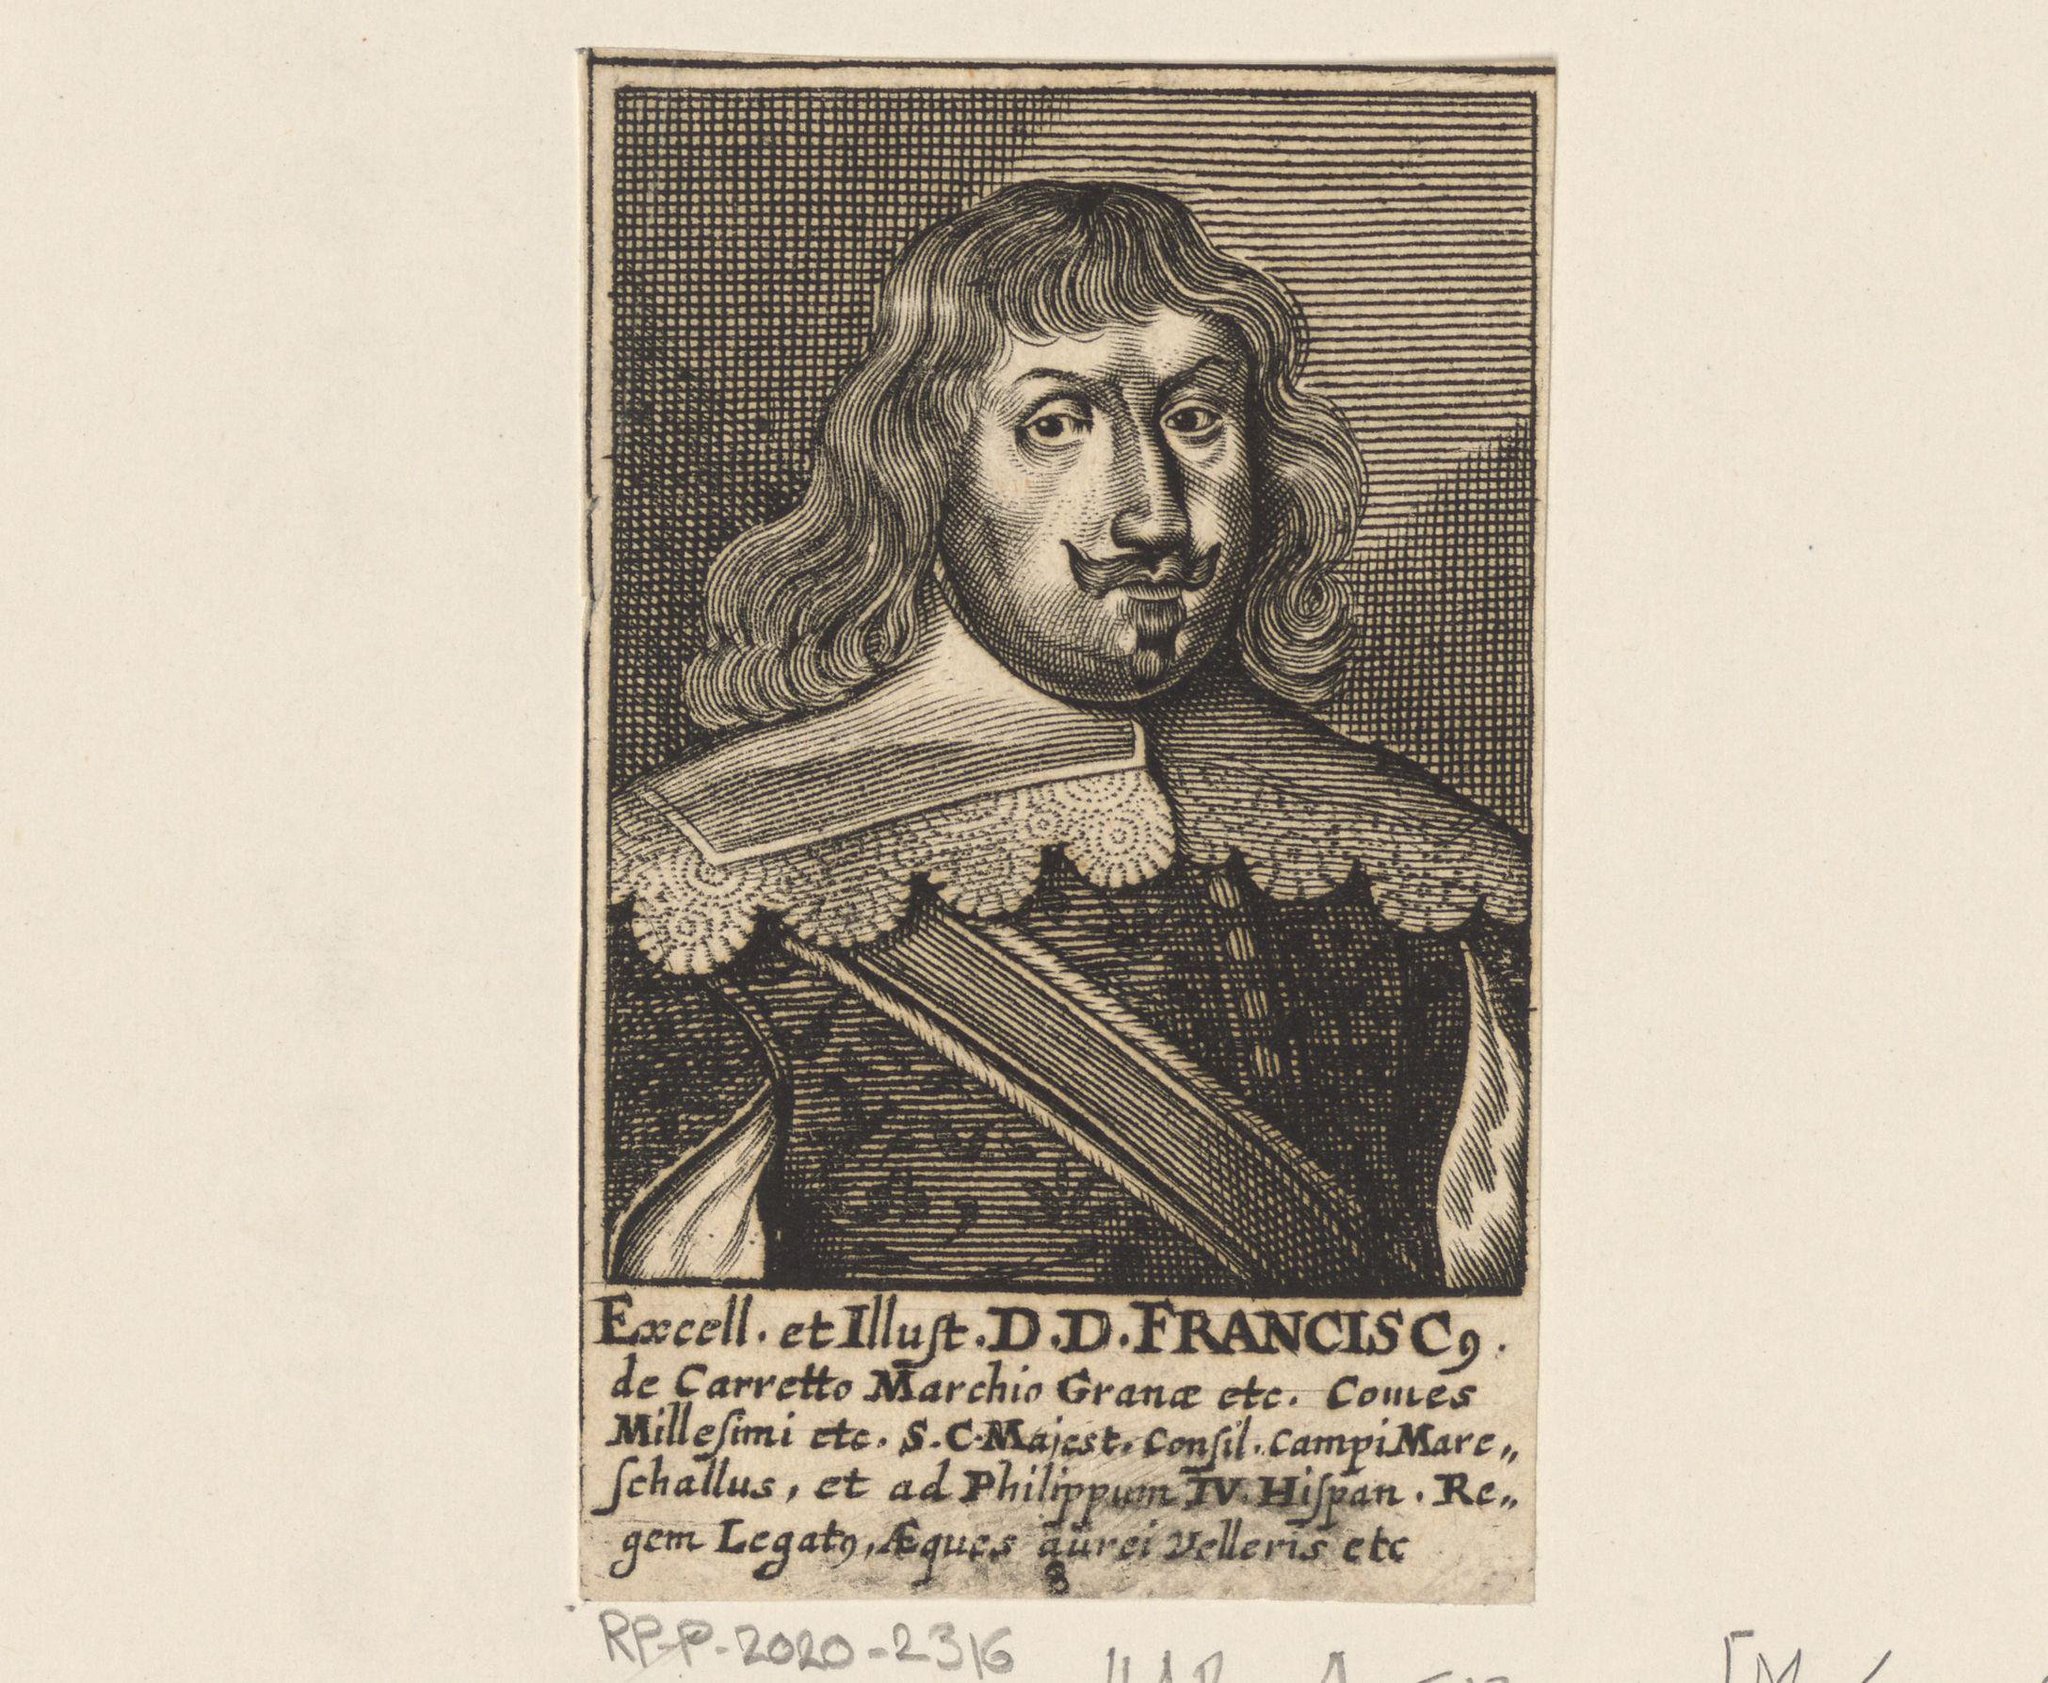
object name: print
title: Portret van Francesco del Carretto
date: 1665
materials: paper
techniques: engraving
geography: nuremberg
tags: vienna, historical persons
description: Andere staat van prent gebruikt in: Meyer, Martin. Ortelius continuatus das ist der Ungarischen Kriegs (...). Neurenberg: Paul Fürst, 1665.